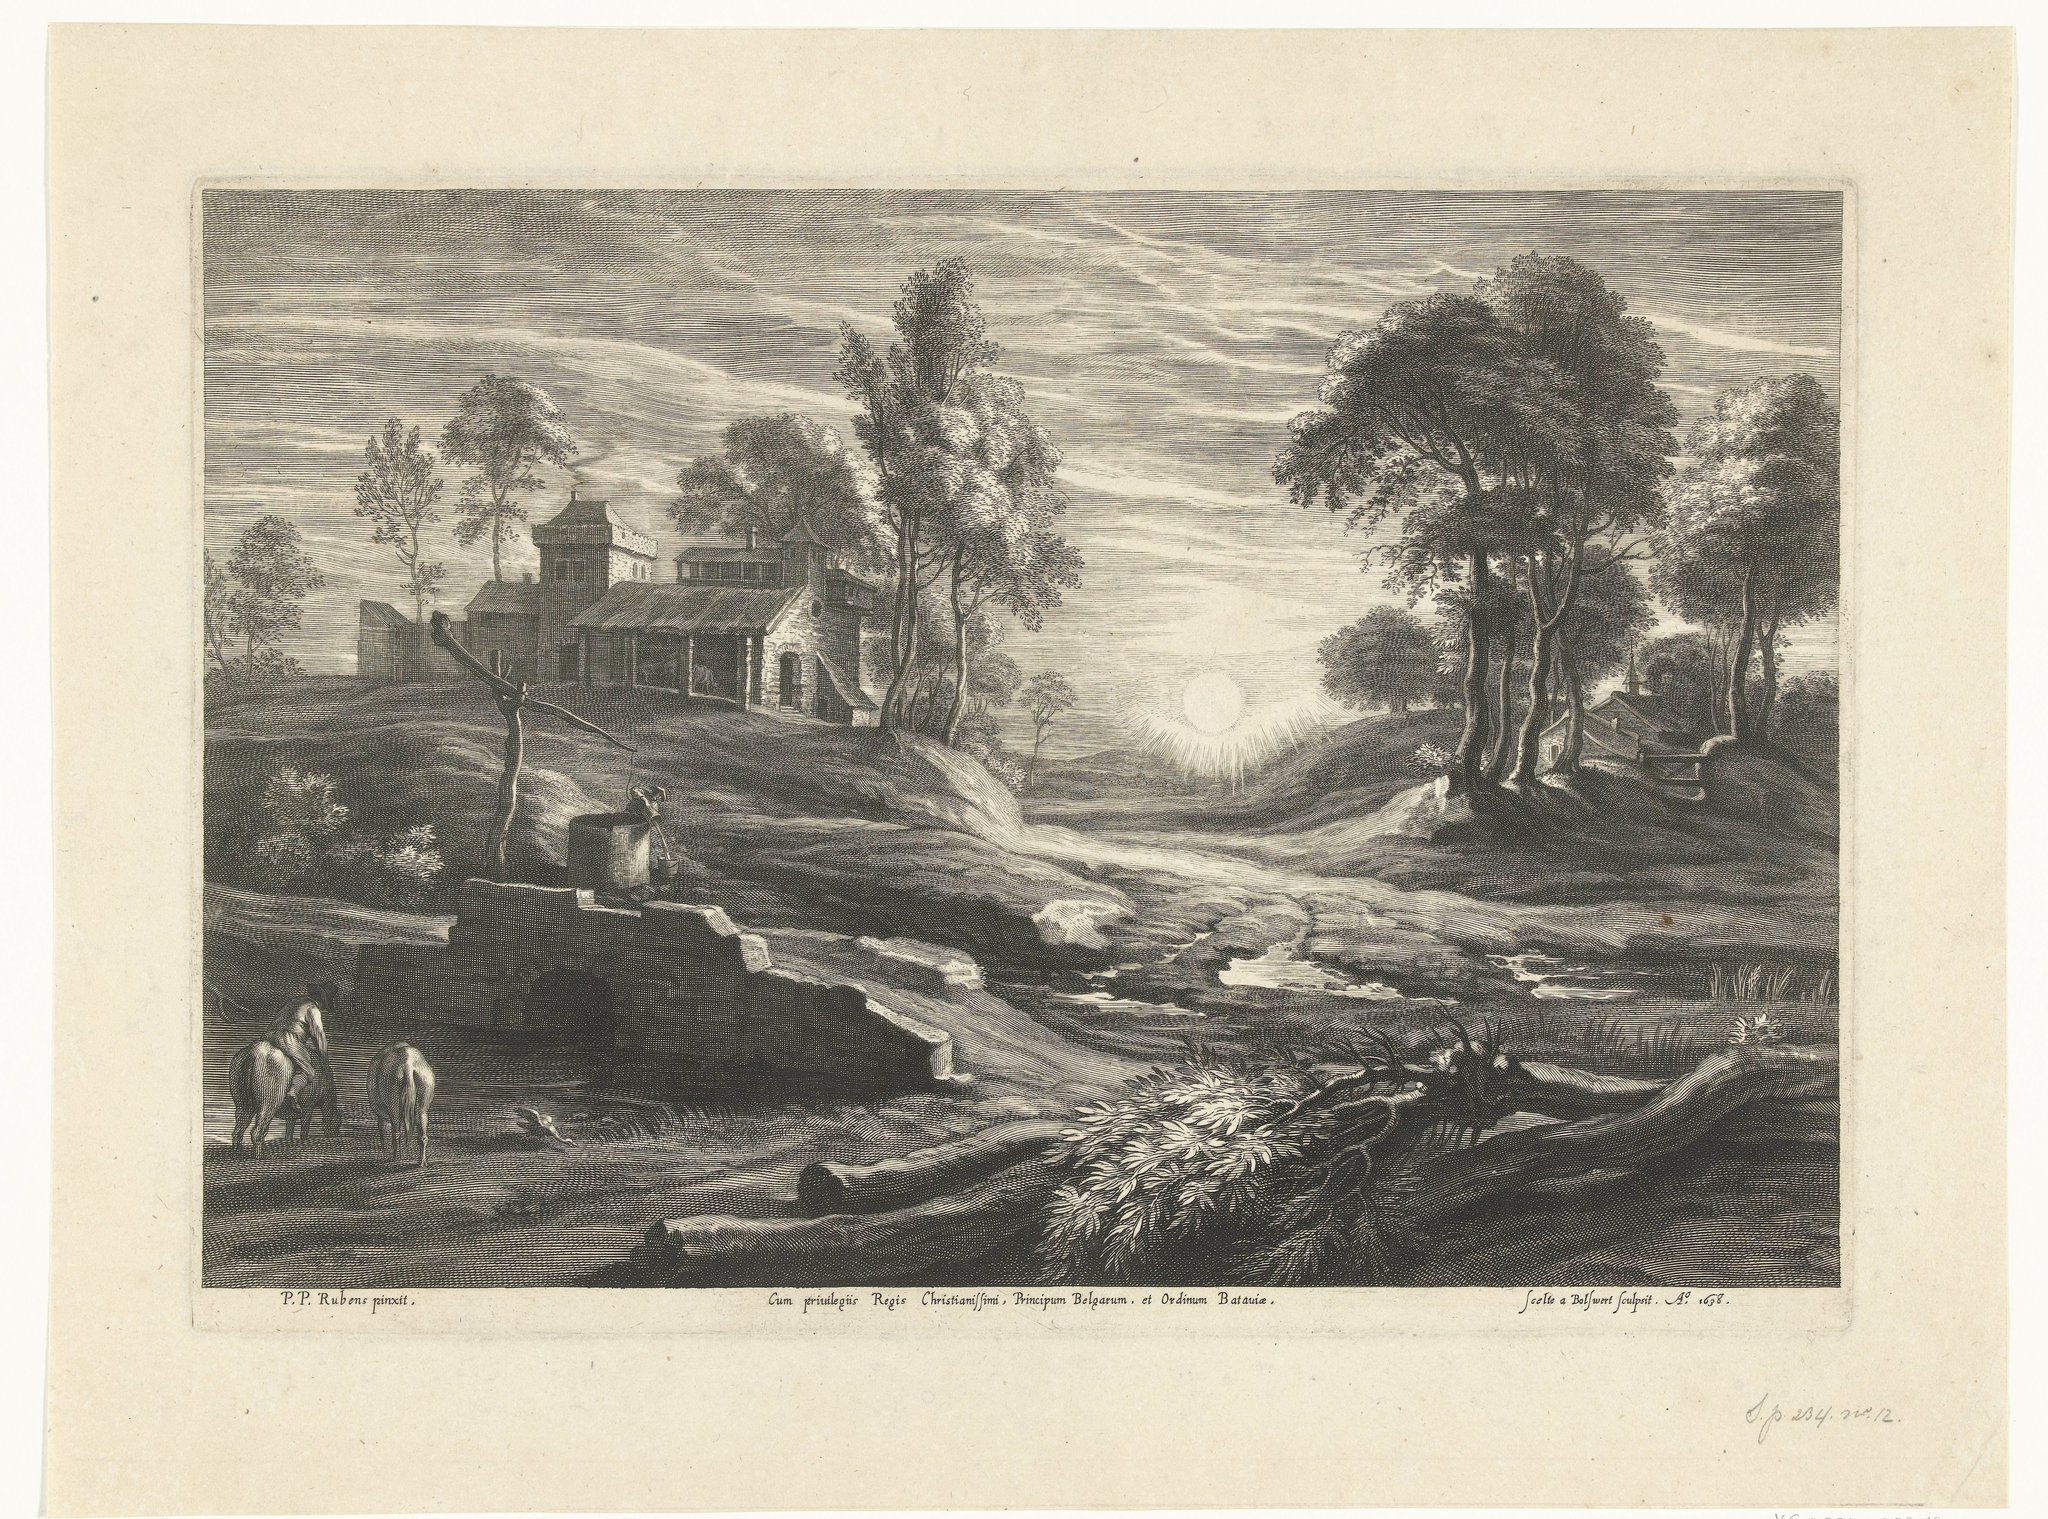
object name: print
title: Landschap met waterput en zon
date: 1638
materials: paper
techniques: engraving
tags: well, sun as celestial body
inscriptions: collector's mark: Lugt 240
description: Prent naar schilderij van Peter Paul Rubens. Hollstein beschrijft een serie kleine landschappen onder de nrs. 305 t/m 325 maar deze prenten zijn niet als reeks vervaardigd. De beschreven staten bij Hollstein lijken niet van toepassing op deze prent, waarschijnlijk betreft het de eerste staat voor het nummer (vergelijk RP-P-1907-2260).